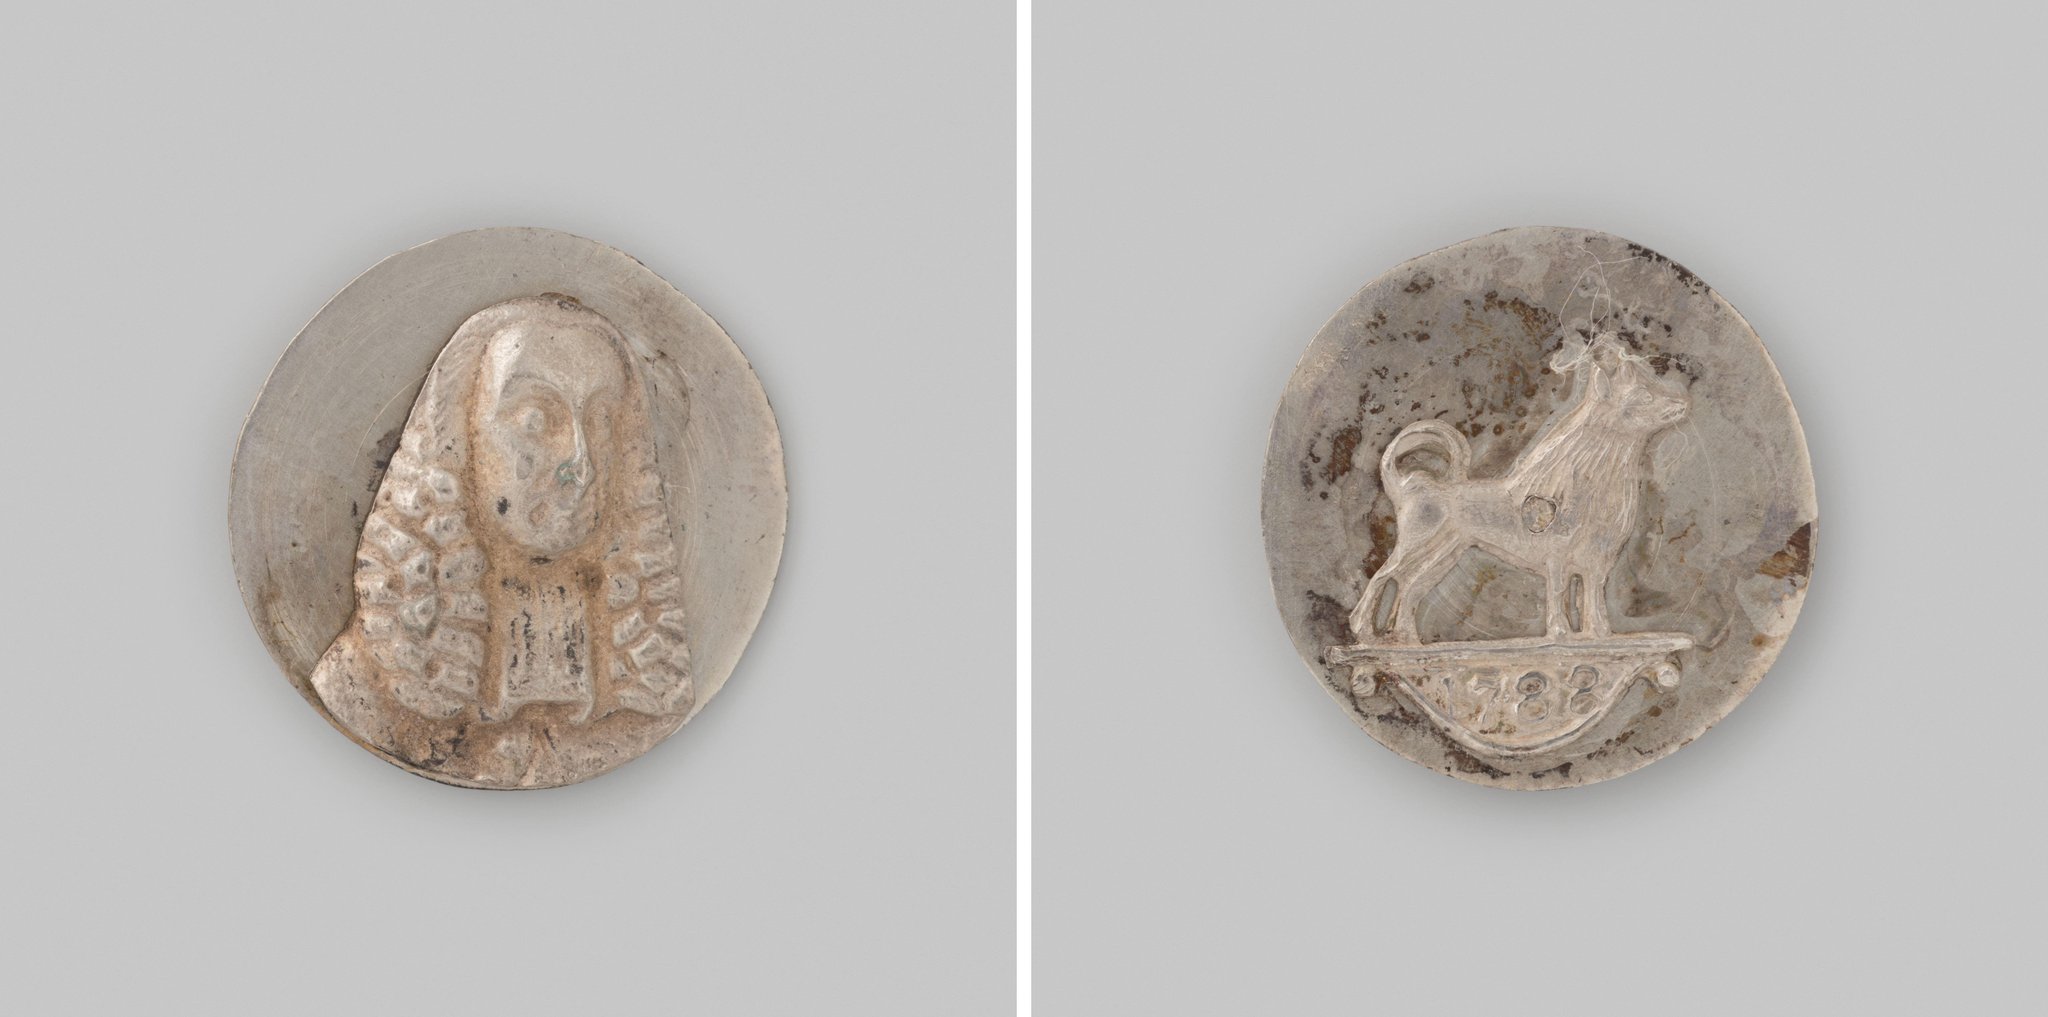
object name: insignia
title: Keeshondje, draagteken ter ere van Hendrik Danielsz. Hooft, burgemeester van Amsterdam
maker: Anonymous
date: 1788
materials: silver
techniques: fastening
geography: netherlands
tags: amsterdam, mayor, hendrik danielsz. hooft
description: Zilveren penning. Voorzijde: borststuk man. Keerzijde: hond met spitse bek, harige kop en nek met manen, glad achterlijf en lange in pluim uitlopende staart, die met lus teruggeslagen op rug hangt boven jaartal